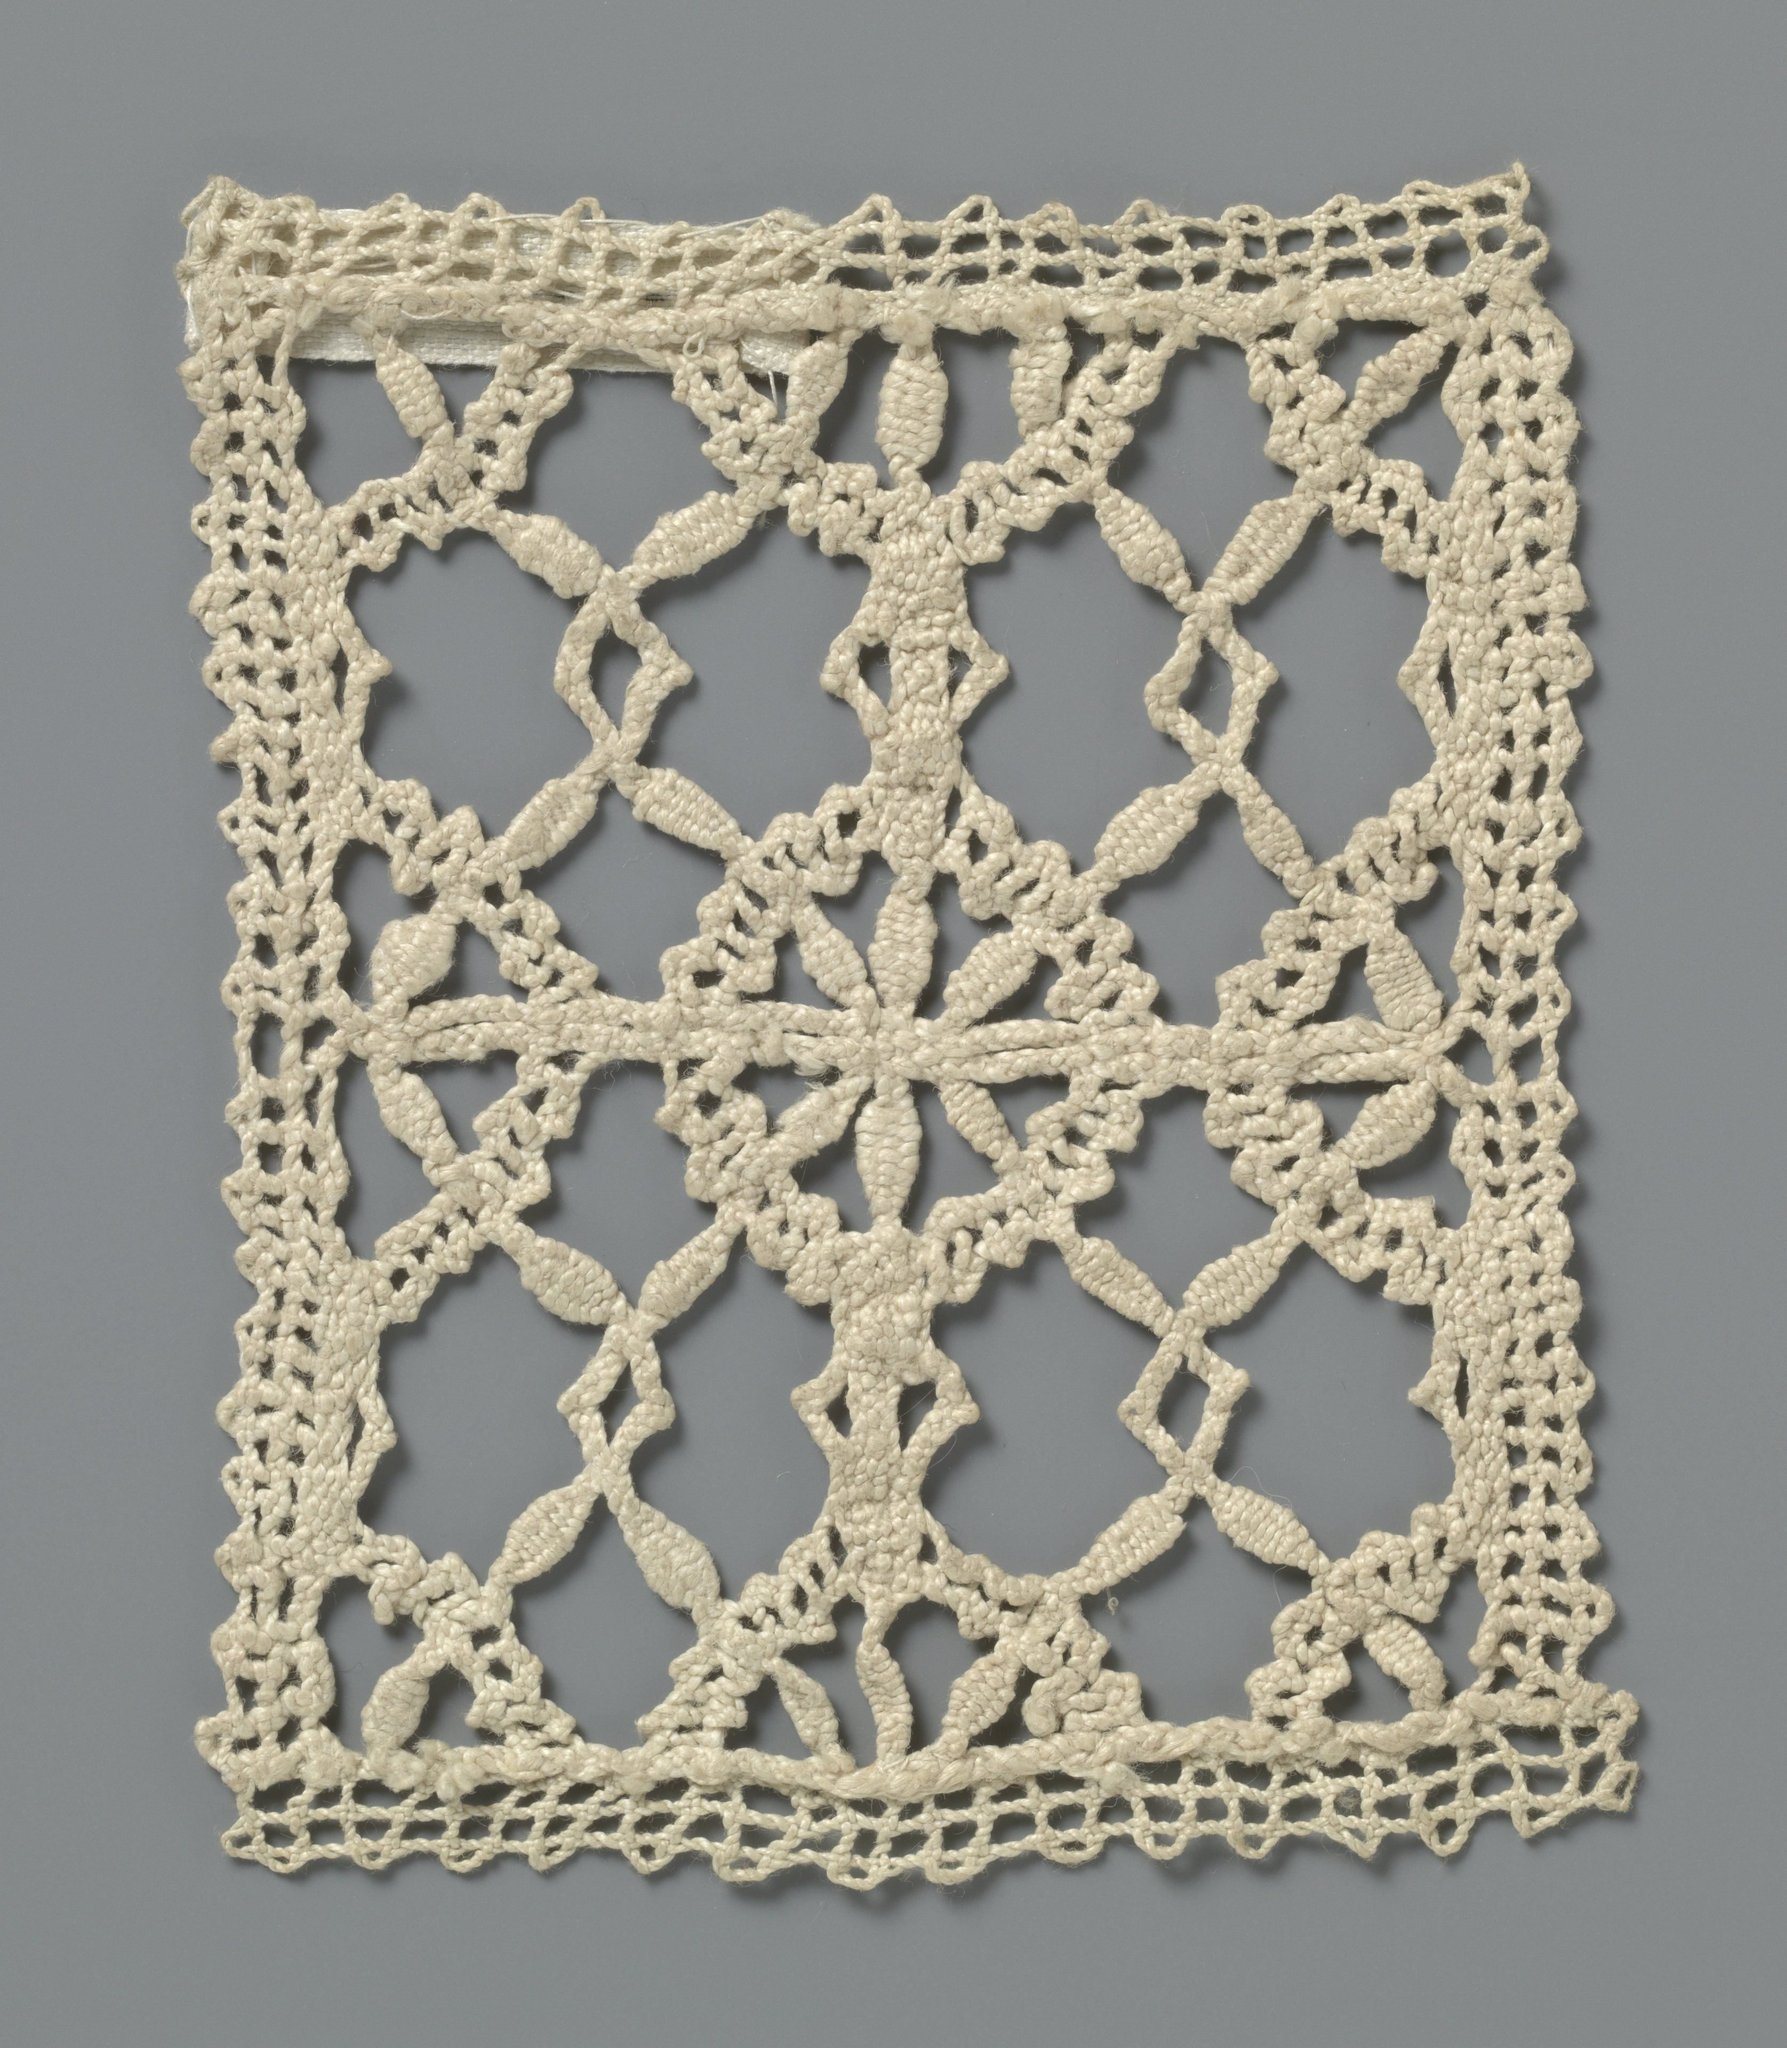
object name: mat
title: Kleedje van kloskant met één hele cirkel tussen vier halve en vier kwart cirkels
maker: Anonymous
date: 1800-1899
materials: linen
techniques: lace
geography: italy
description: Kleedje van naturelkleurige Genuese kloskant. Rechthoekig model. Het kleedje is met een horizontale en vertikale lijn in vieren gedeeld. Rond elk hoekpunt van de vier kleinere rechthoeken die zo ontstaan, is een cirkel gemaakt met daarin zes blaadjes als spaken in een wiel. Alleen de cirkel in het centrum van het kleedje is heel. In de hoeken van het kleedje is alleen een kwart van de cirkels te zien en langs de zijkanten halve cirkels. De cirkels zijn in het centrum van de kleinere rechthoeken met elkaar verbonden door een ruitje tussen vier blaadjes. De motieven zijn gemaakt met vlechten en in bladvormige vormslag. De zijkanten van het kleedje zijn afgewerkt met een randje dat bestaat uit twee rijen vierkante mazen, aan de buitenrand voorzien van picots.